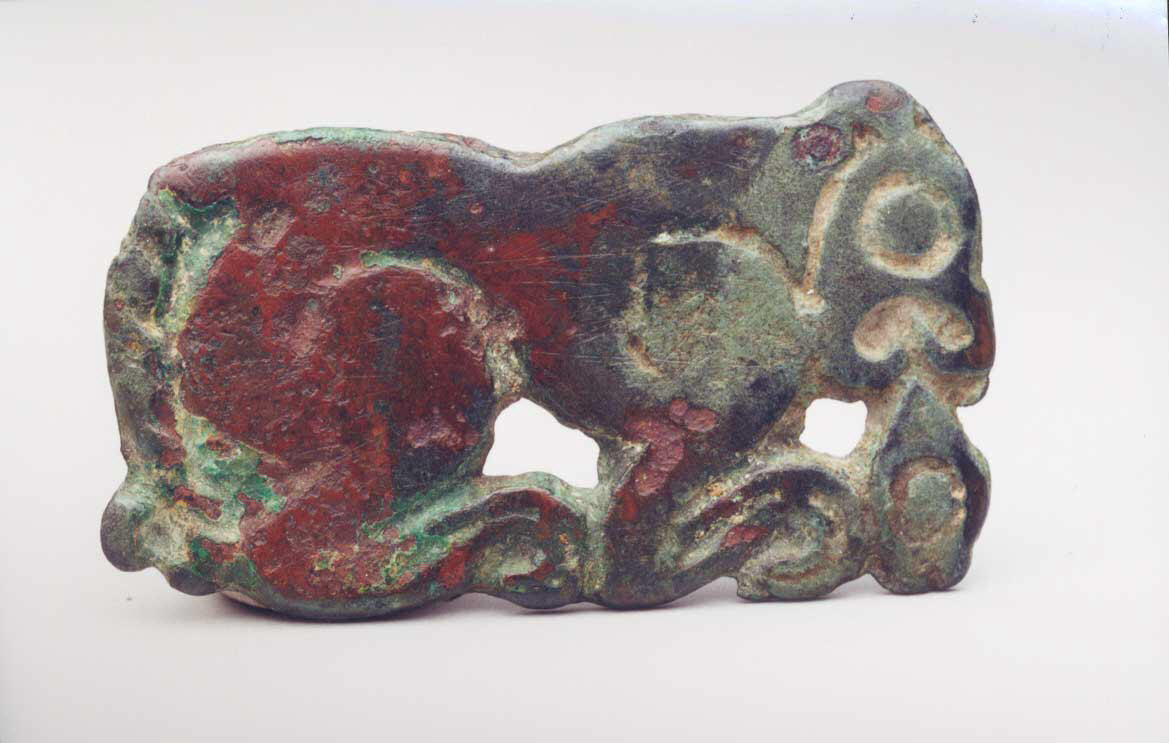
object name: belt plaque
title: Belt Plaque in the Shape of a Crouching Carnivore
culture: chinese or mongolian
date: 500-401 BCE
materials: bronze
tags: animals